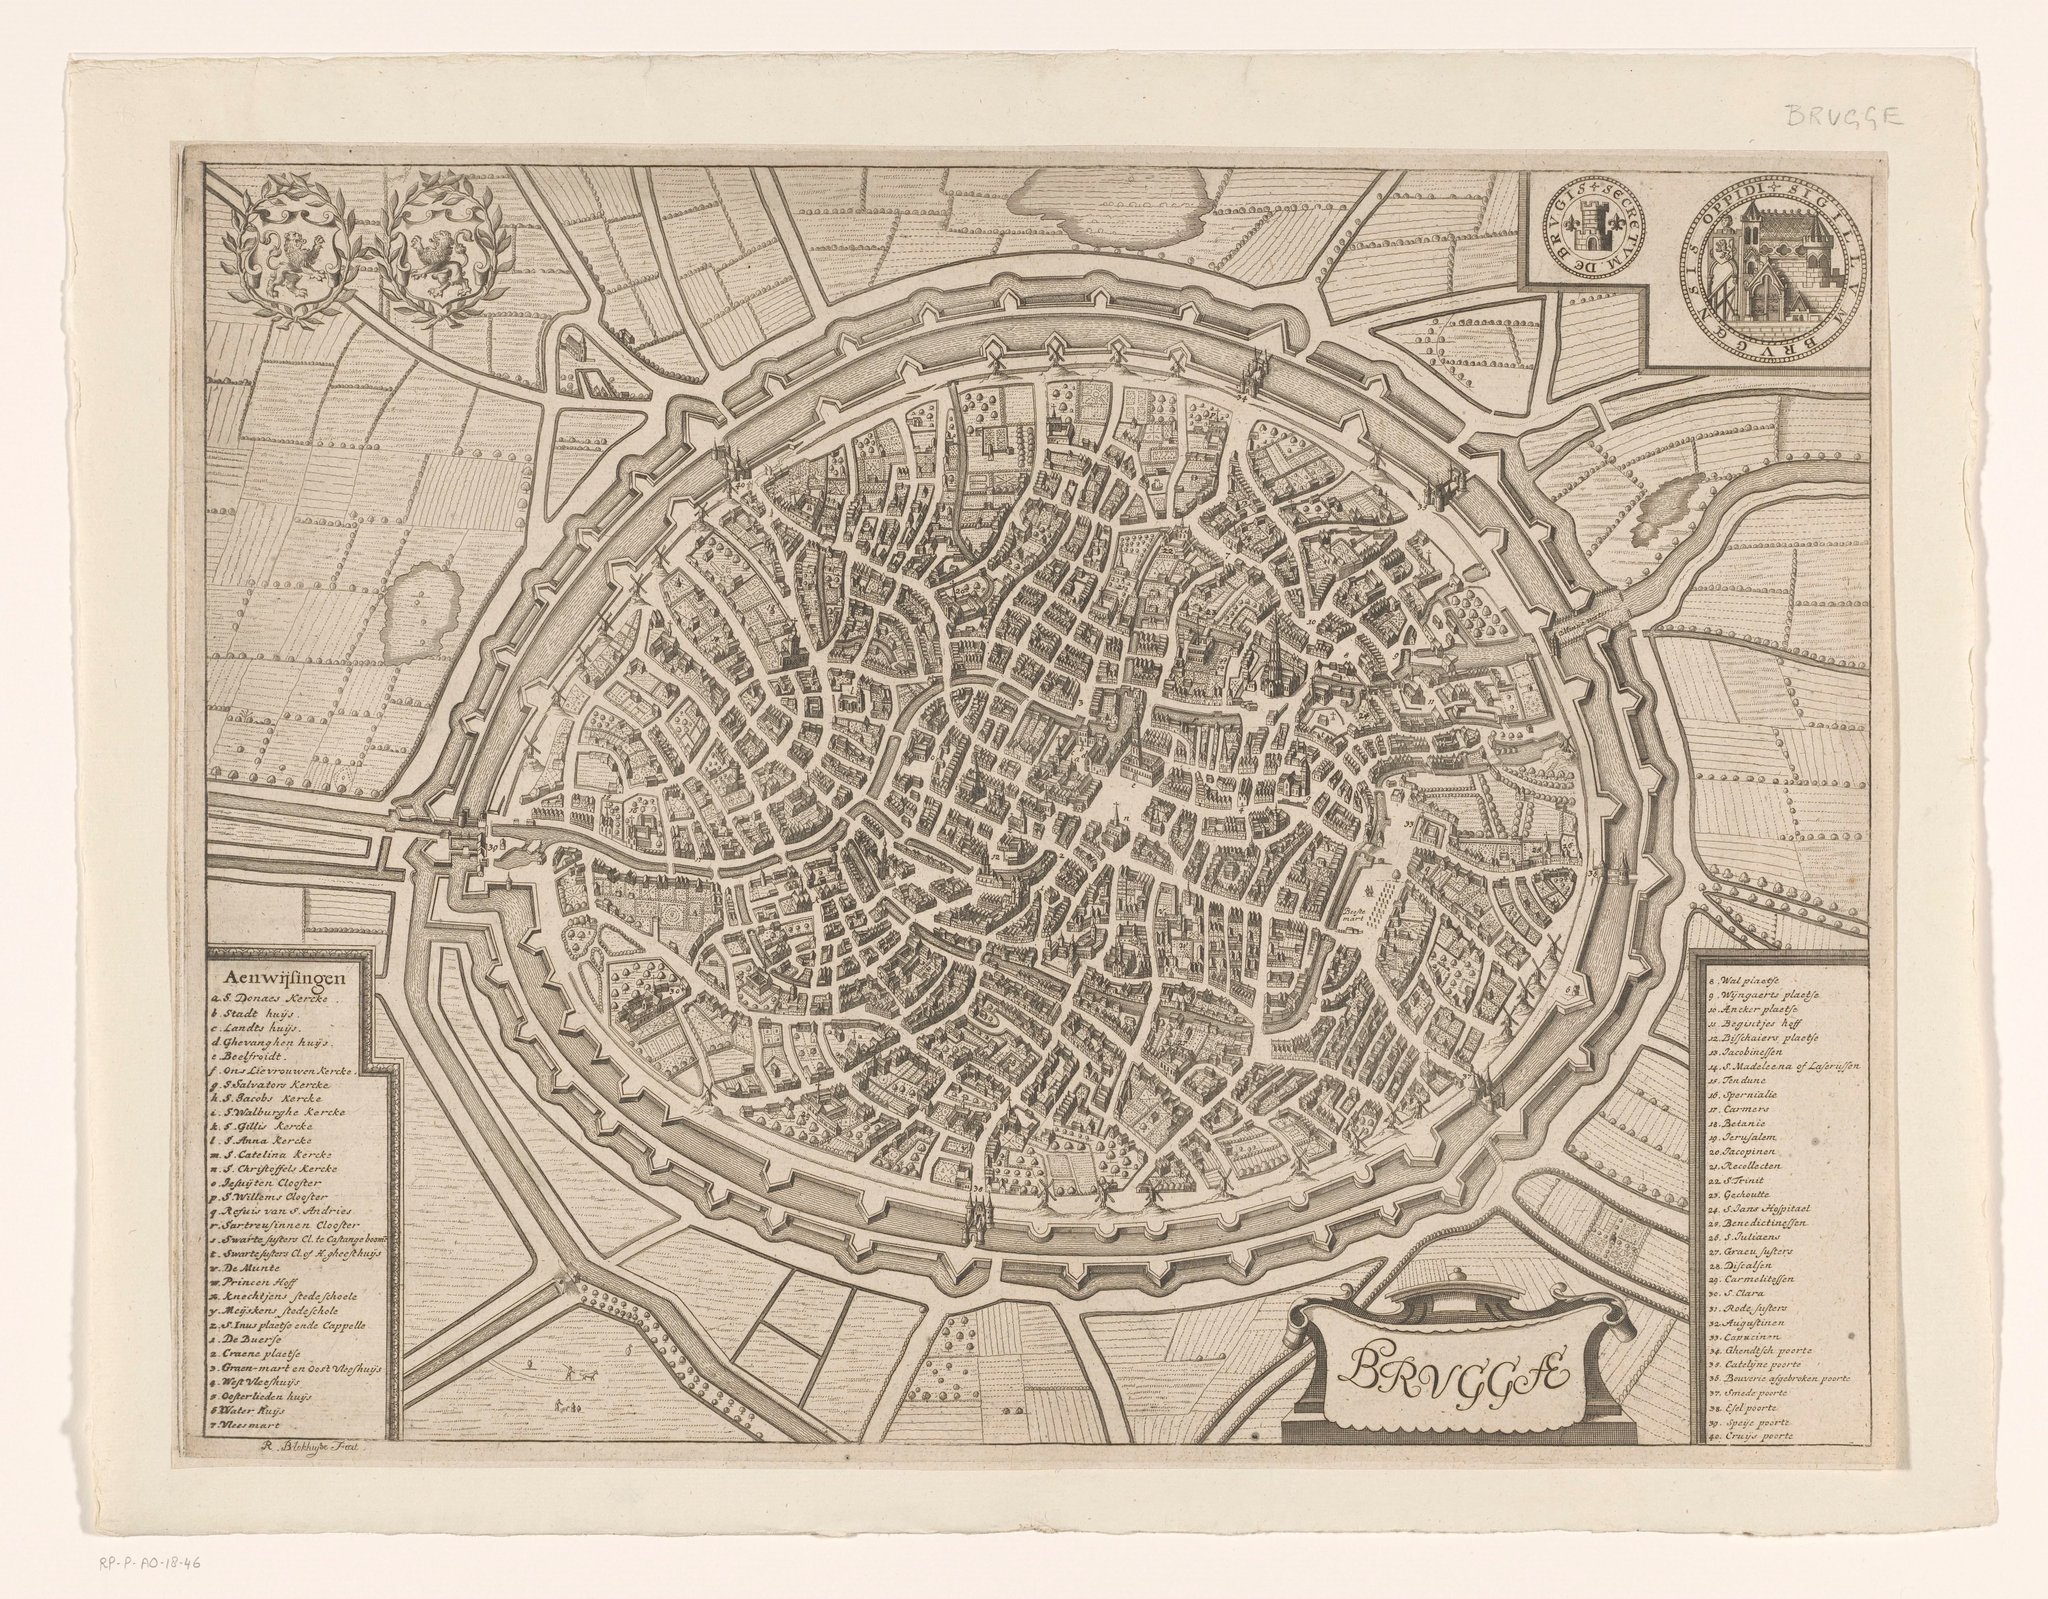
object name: area plan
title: Plattegrond van Brugge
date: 1732-1735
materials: paper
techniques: engraving, etching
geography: the hague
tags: coat of arms (as symbol of the state, etc.) (+ city; municipal), seal (as symbol of the state, etc.) (+ city; municipal), maps of cities, coat of arms (as symbol of the state, etc.) (+ province; provincial), bruges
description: Plattegrond van Brugge met gebouwen in vogelvluchtperspectief. Onder, rechts van het midden, een cartouche met de titel. Linksonder een kader met legenda A-Z en 1-7. Rechtsonder een kader het vervolg van de legenda, 8-40. Linksboven tweemaal het wapen van het graafschap Vlaanderen, links gespiegeld. Rechtsboven een kader met daarin twee zegels van Brugge. Op verso Nederlandse tekst.